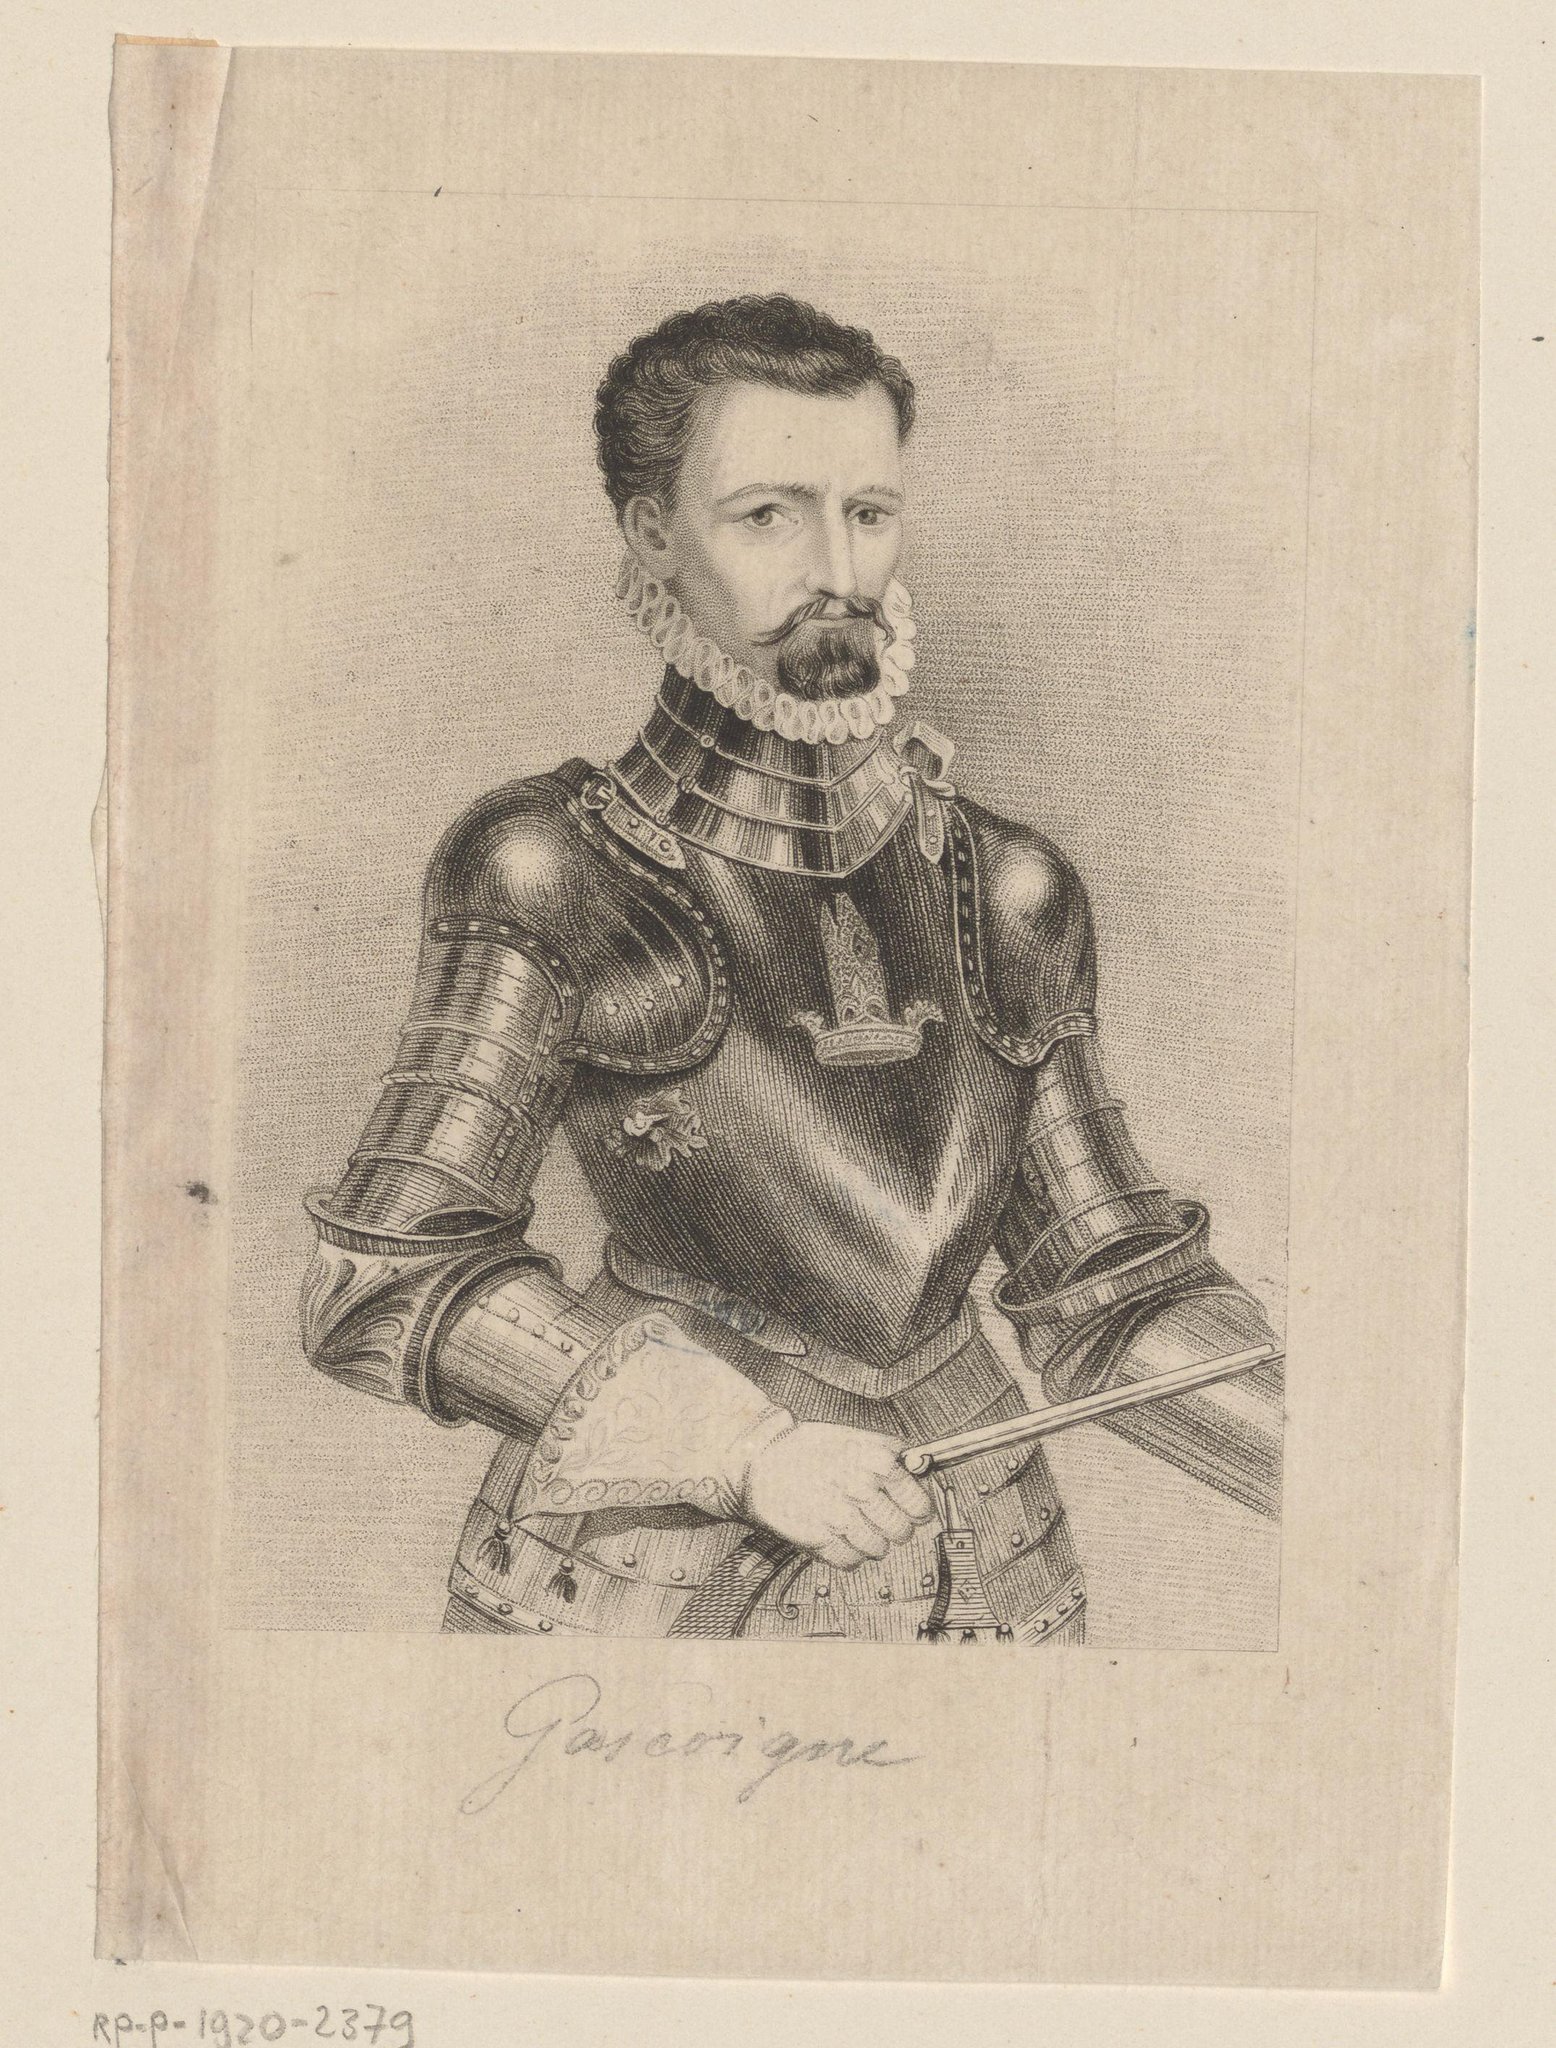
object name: print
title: Portret van George Gascoigne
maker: Anonymous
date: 1600-1700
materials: paper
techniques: stippling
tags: politician, historical persons, writer, poet, author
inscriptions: collector's mark: Lugt 2228